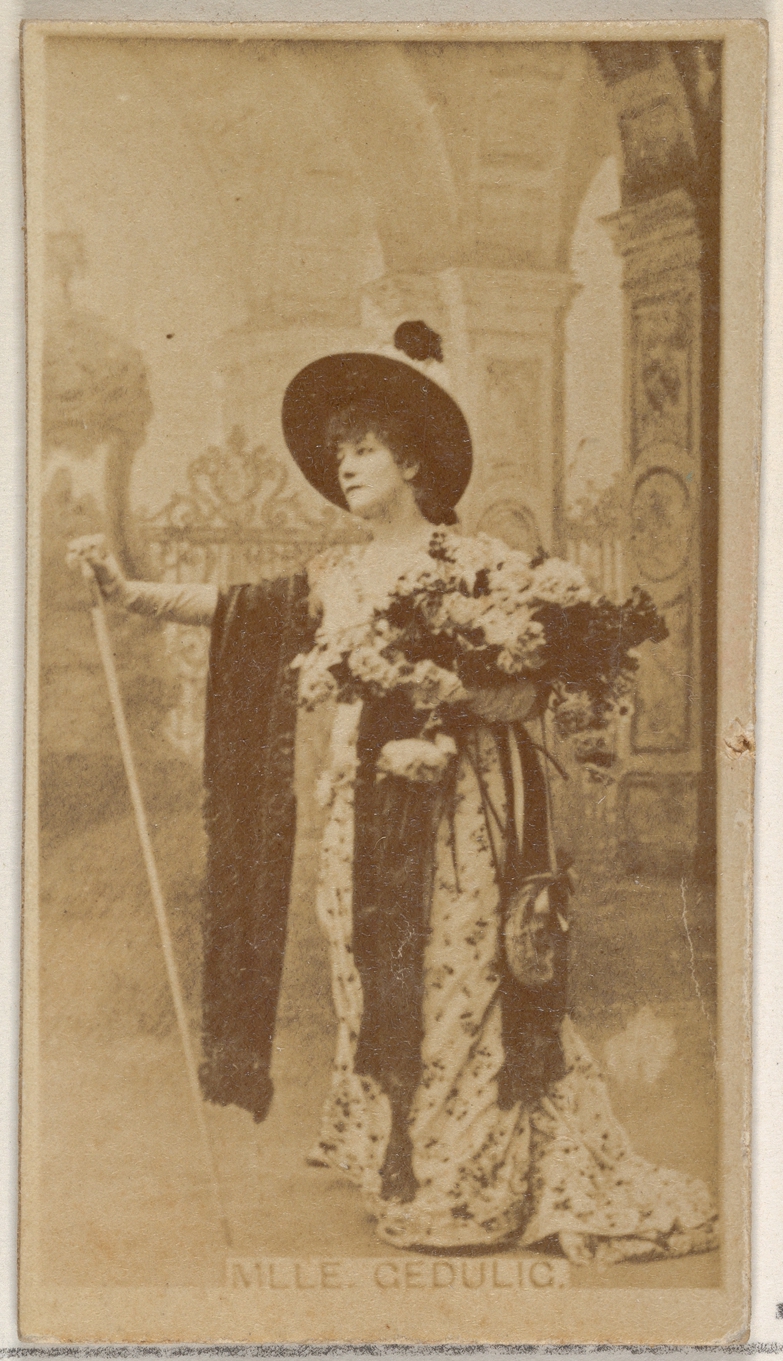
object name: photograph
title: Mlle. Gedulic, from the Actors and Actresses series (N45, Type 8) for Virginia Brights Cigarettes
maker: allen & ginter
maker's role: publisher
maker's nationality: american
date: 1888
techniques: albumen silver print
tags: portraits,women,actresses